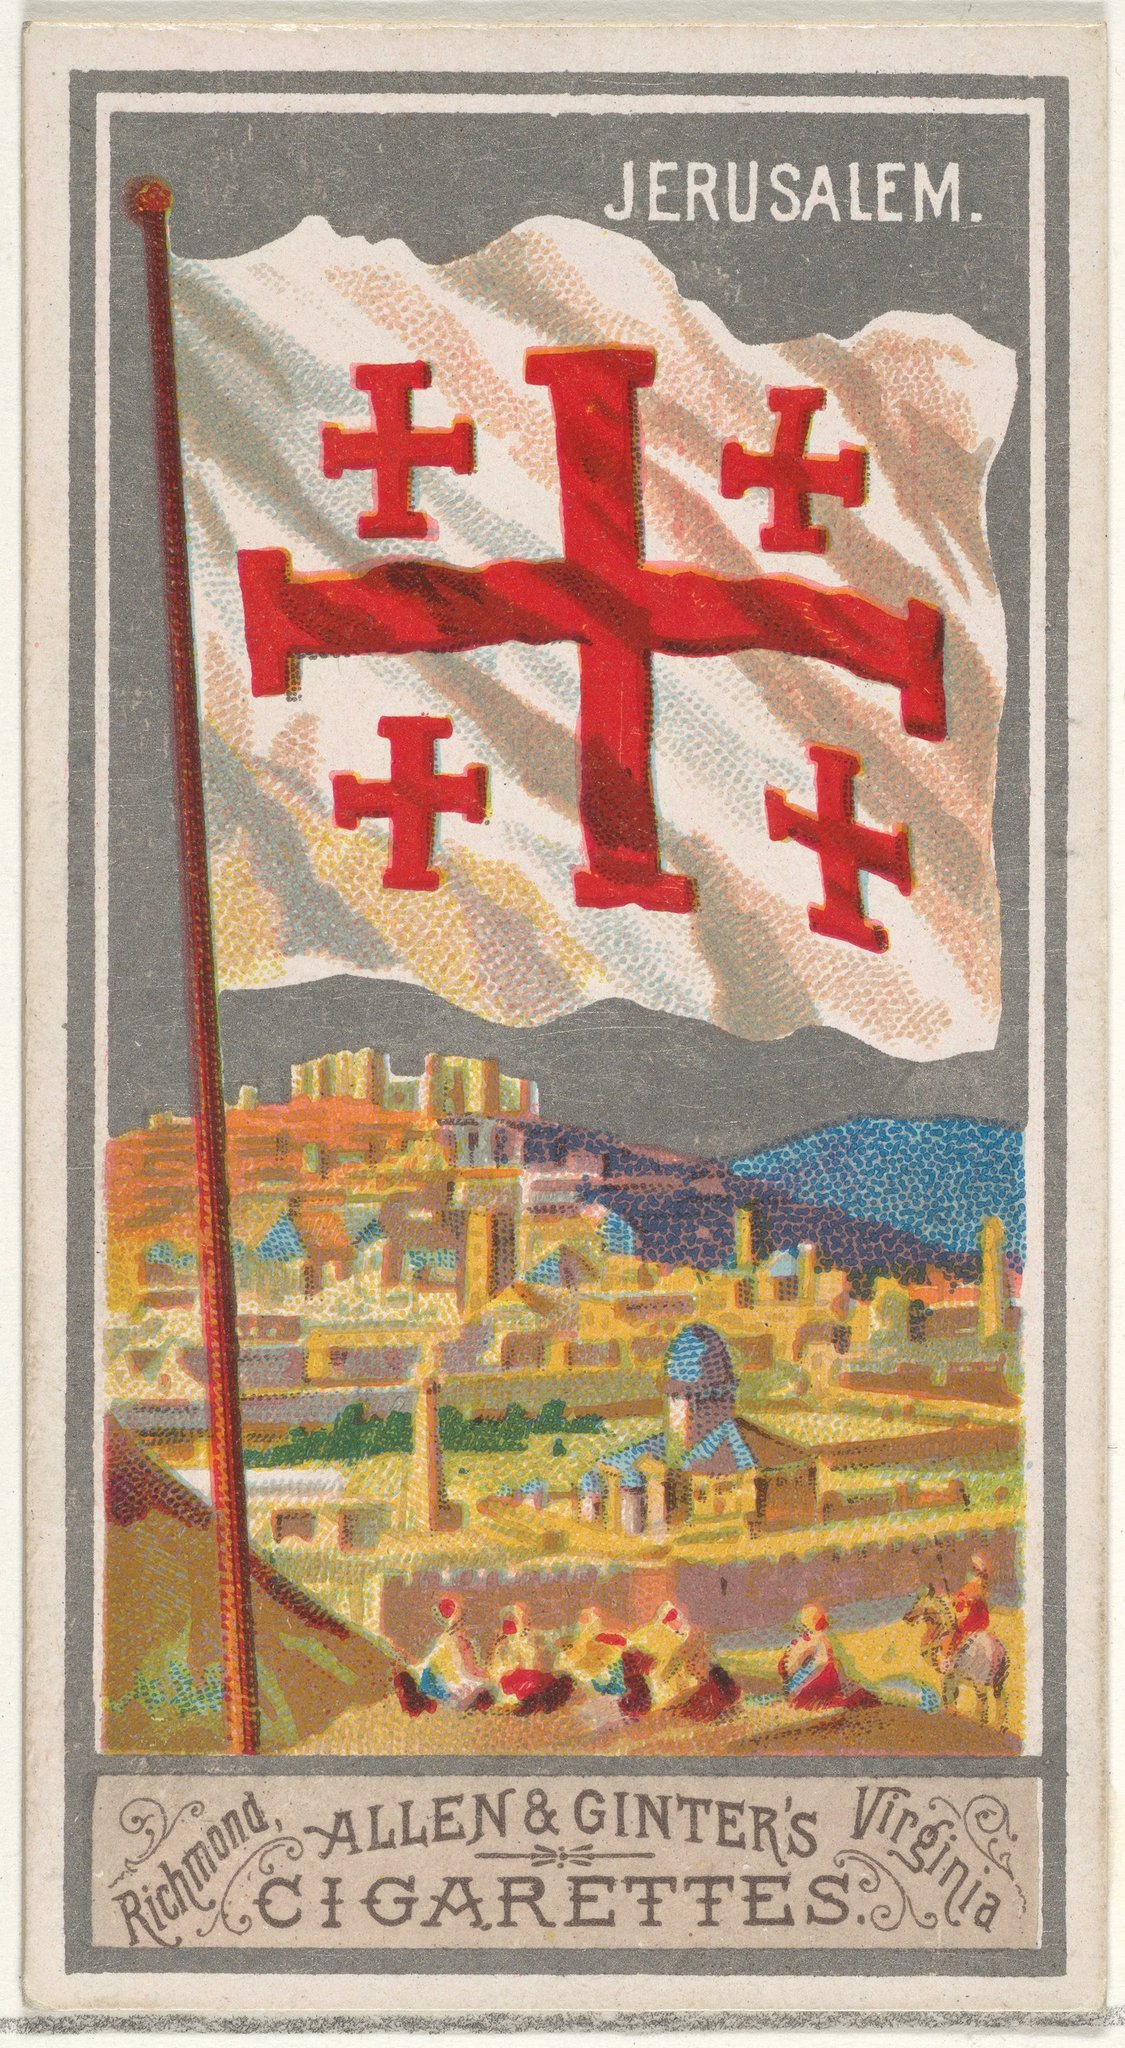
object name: print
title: Jerusalem, from the City Flags series (N6) for Allen & Ginter Cigarettes Brands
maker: allen & ginter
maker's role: publisher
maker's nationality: american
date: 1887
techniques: color lithograph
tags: coat of arms,flags